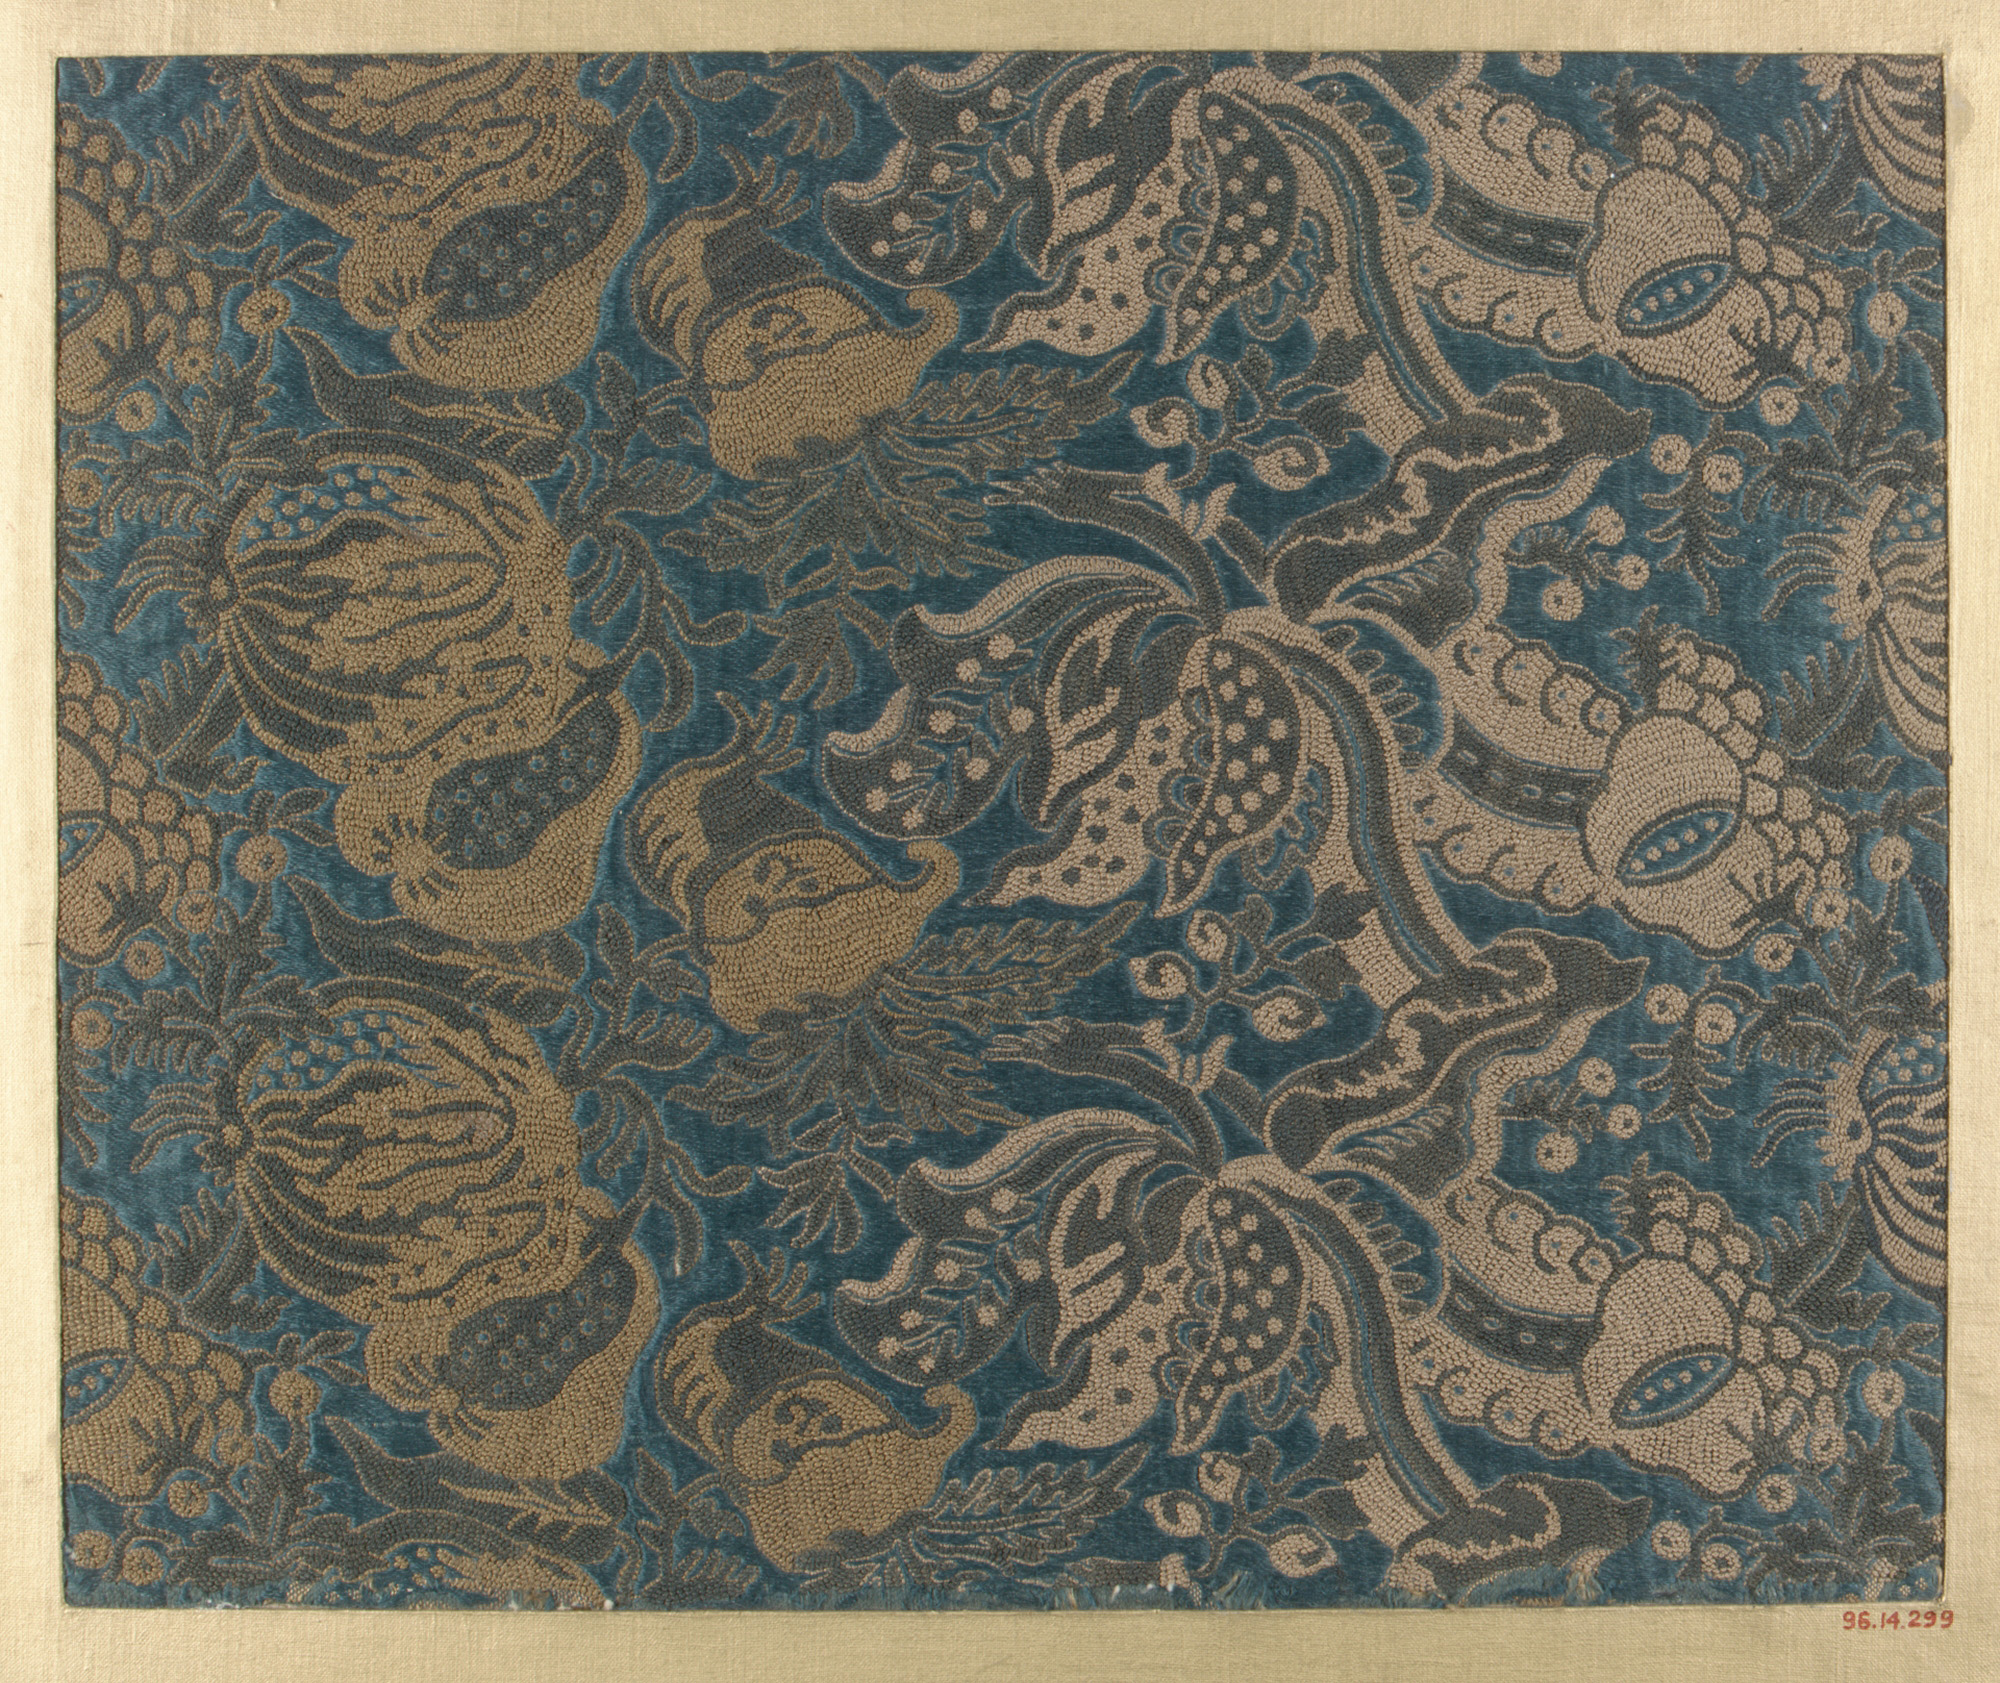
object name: piece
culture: japanese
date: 1701-1900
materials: silk